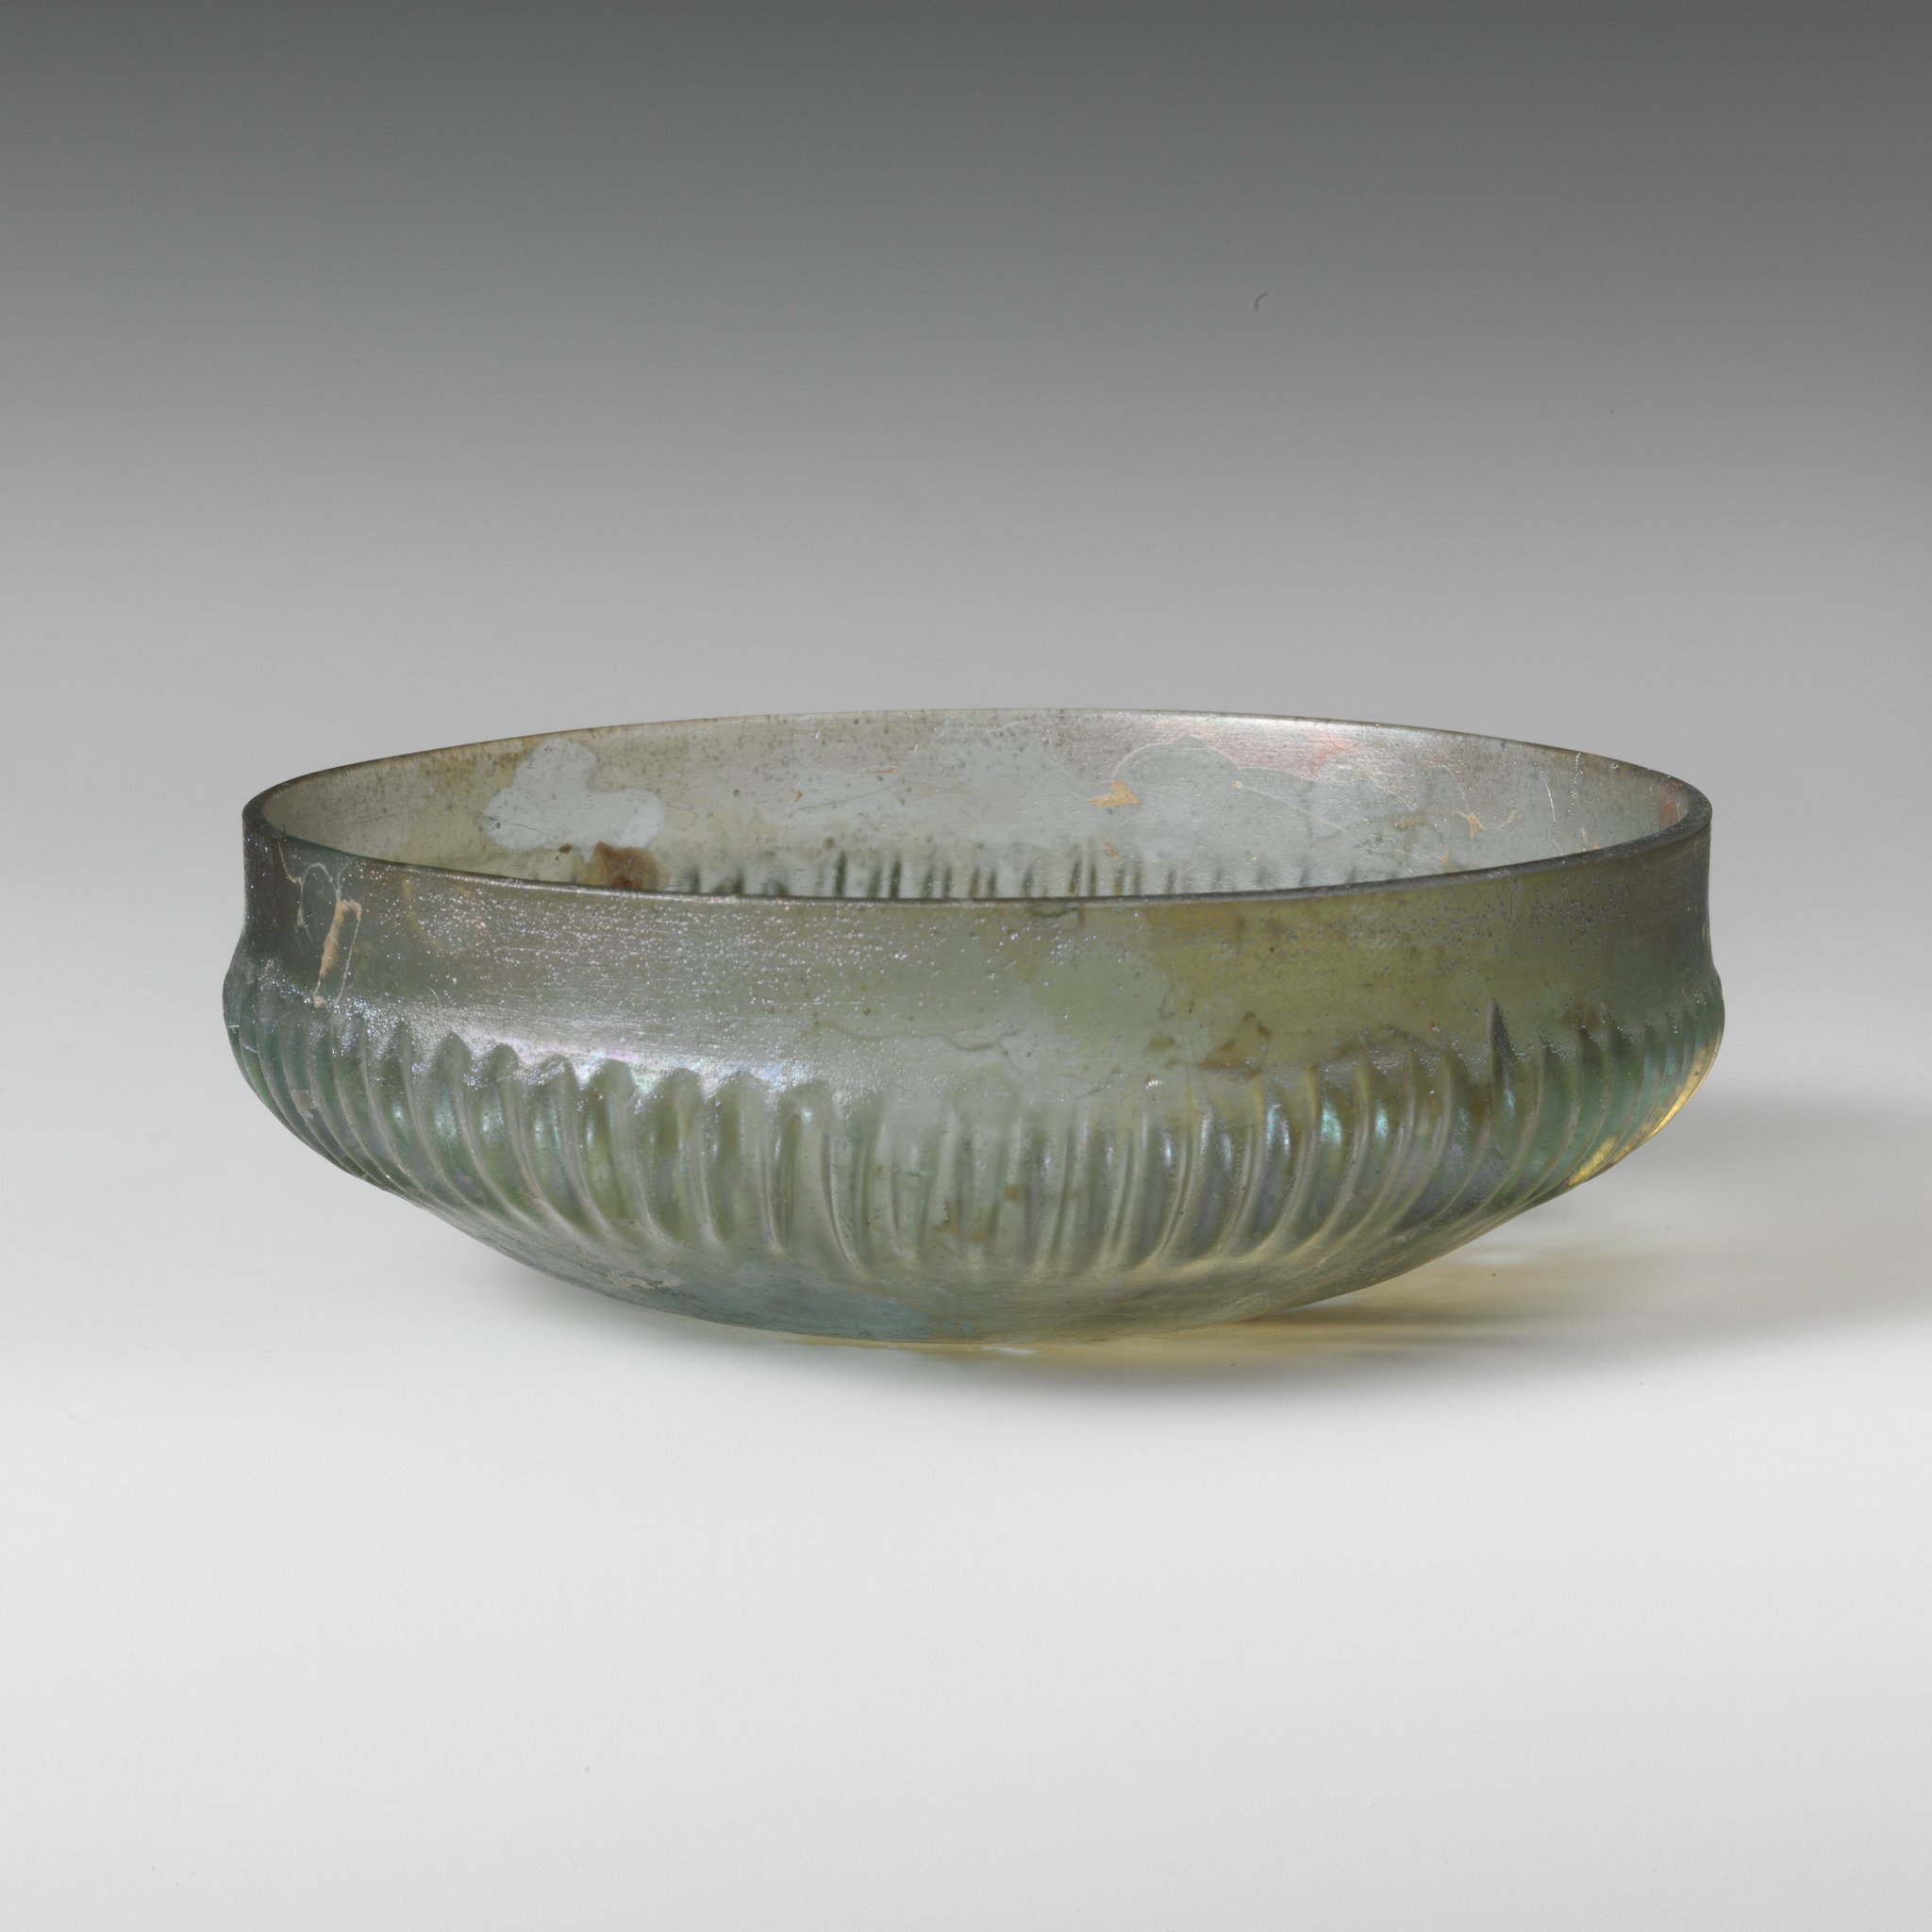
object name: bowl, ribbed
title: Glass ribbed bowl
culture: roman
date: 1-33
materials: glass